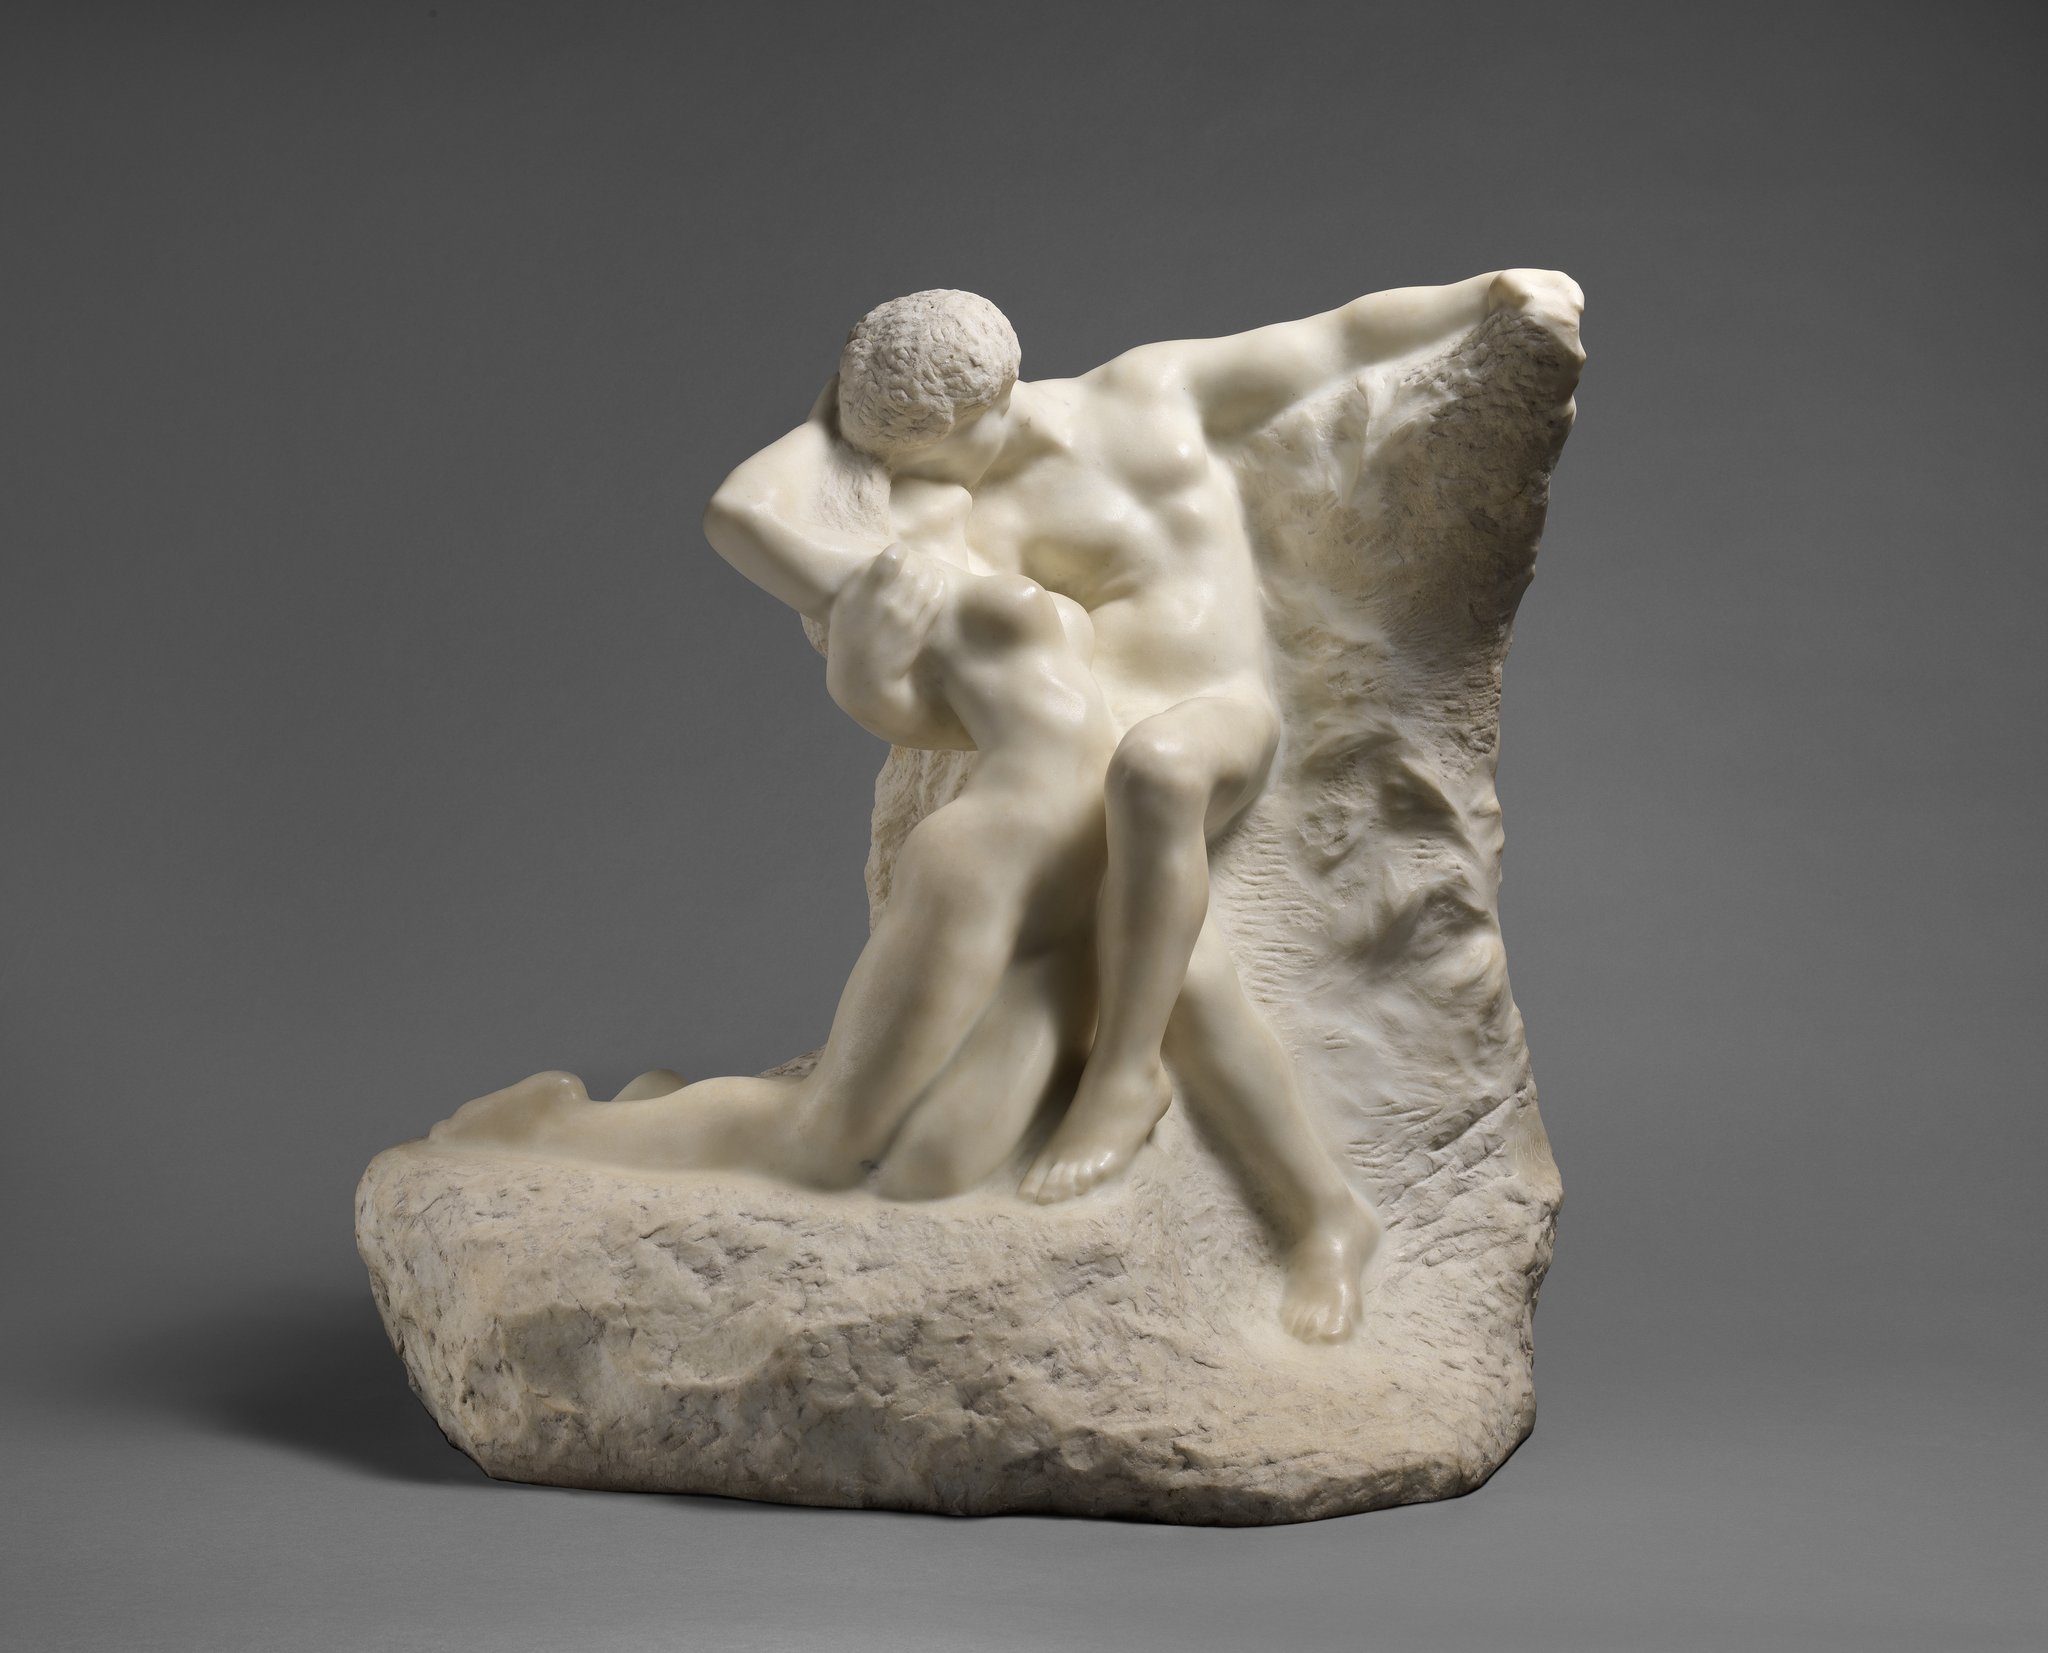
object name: group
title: Eternal Spring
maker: auguste rodin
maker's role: artist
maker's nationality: french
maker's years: 1840-1917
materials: marble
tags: couples,male nudes,lovers,female nudes